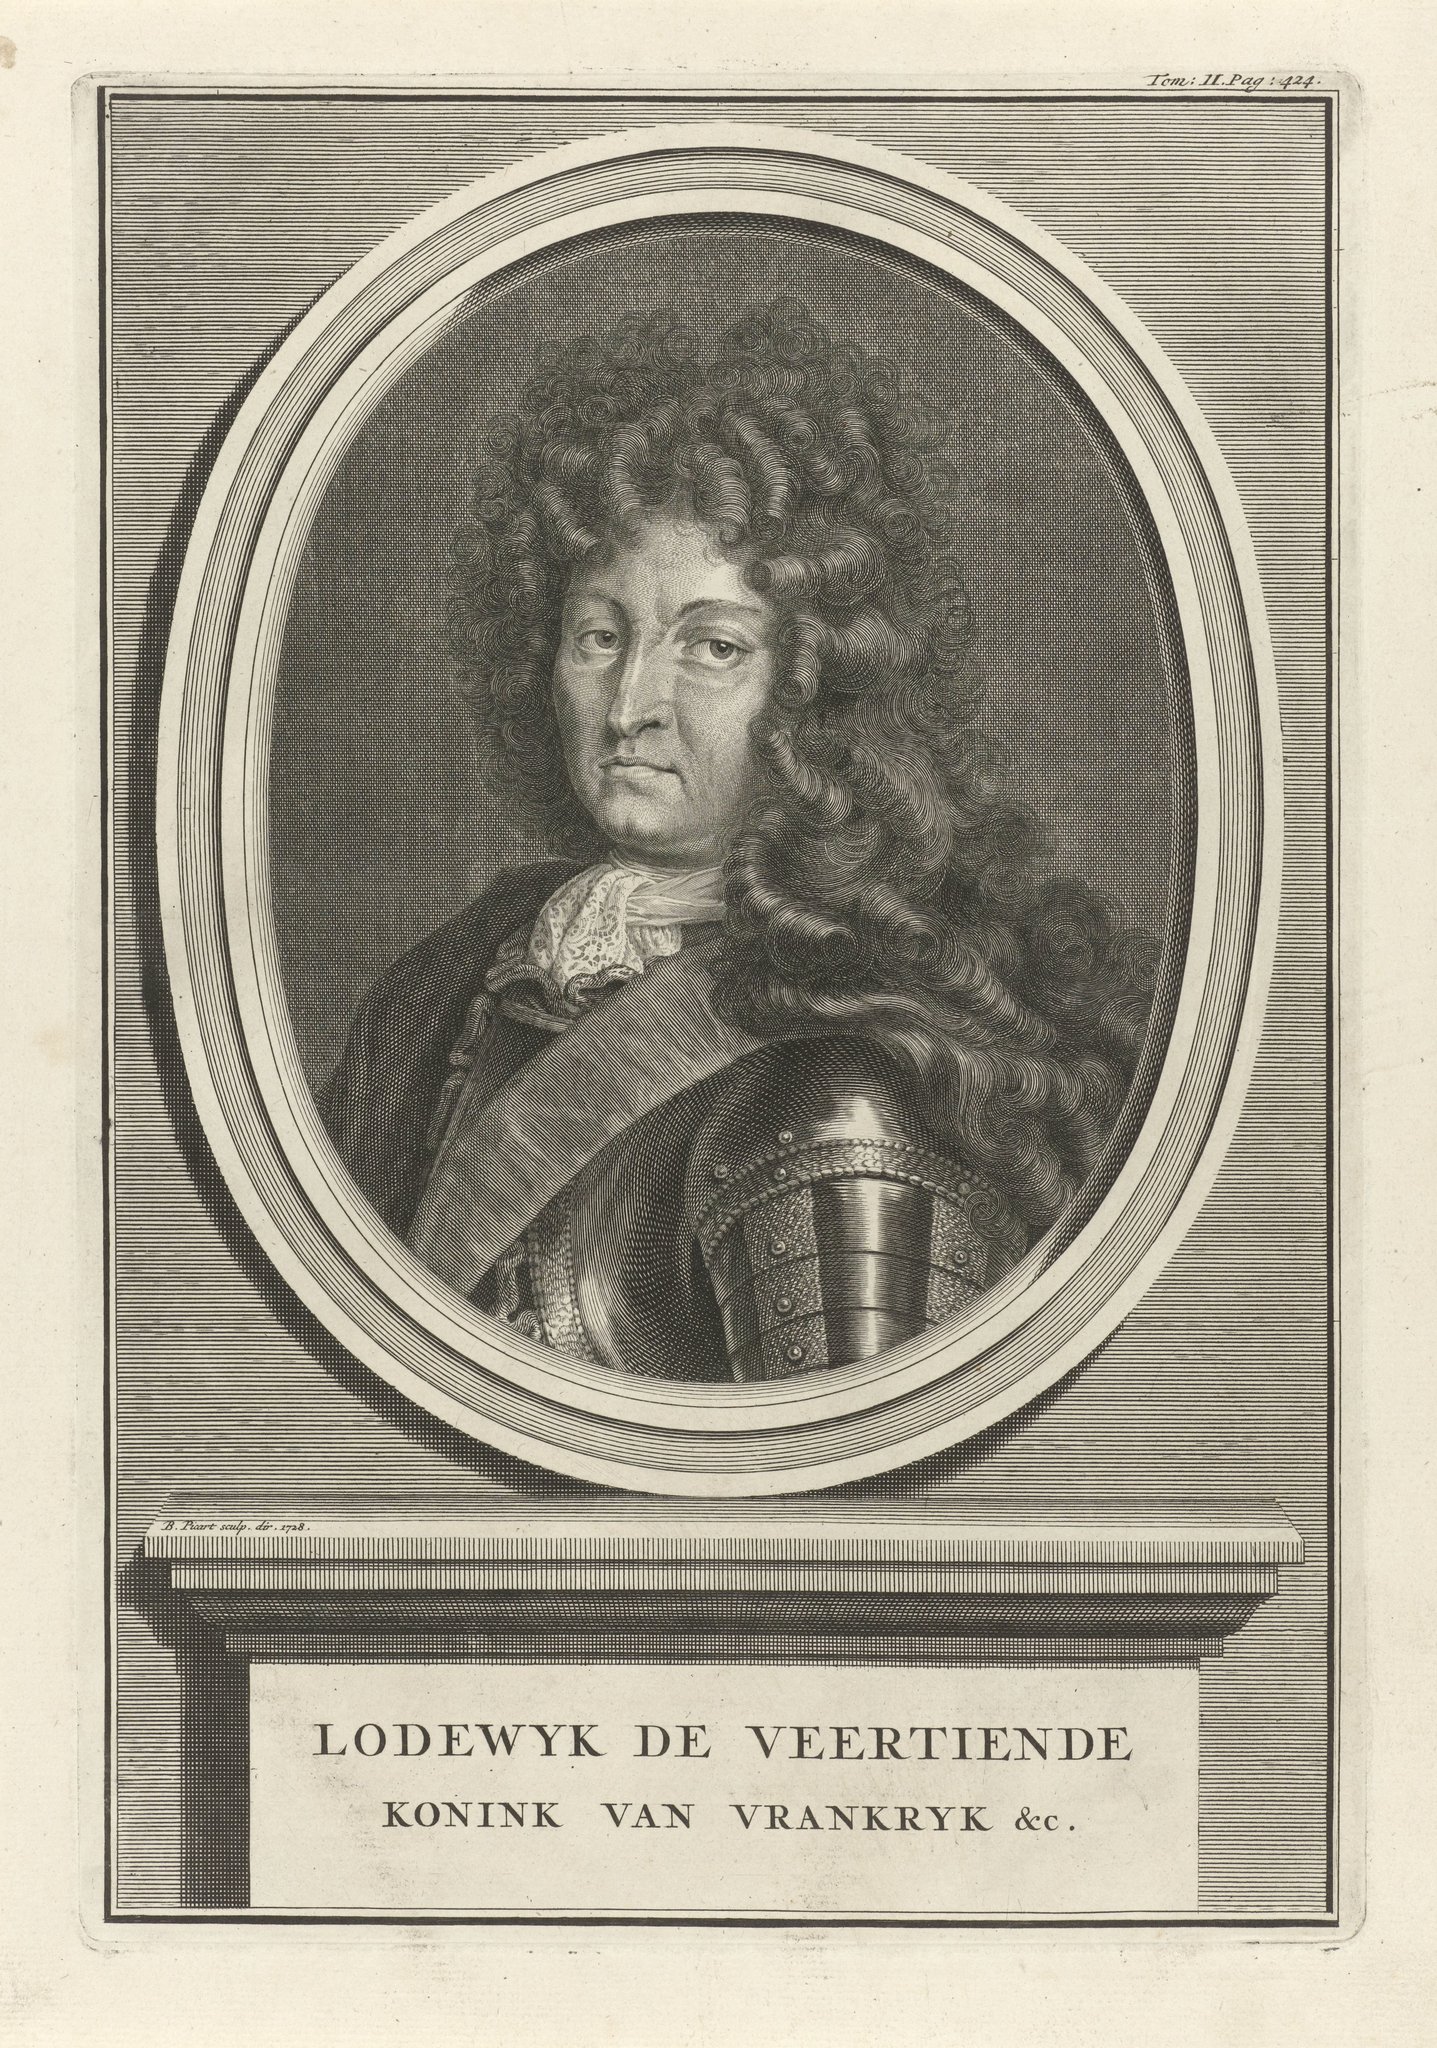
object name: print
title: Portret van Lodewijk XIV, koning van Frankrijk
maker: bernard picart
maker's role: draughtsman, print maker, publisher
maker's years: 1673-1733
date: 1728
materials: paper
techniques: engraving, etching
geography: amsterdam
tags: lodewijk xiv (koning van frankrijk), armour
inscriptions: collector's mark: Lugt 2228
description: Prent als illustratie gebruikt in: Le Clerc, Jean. Geschiedenissen der Vereenigde Nederlanden. Amsterdam: Zacharias Chatelain (II), 1730.